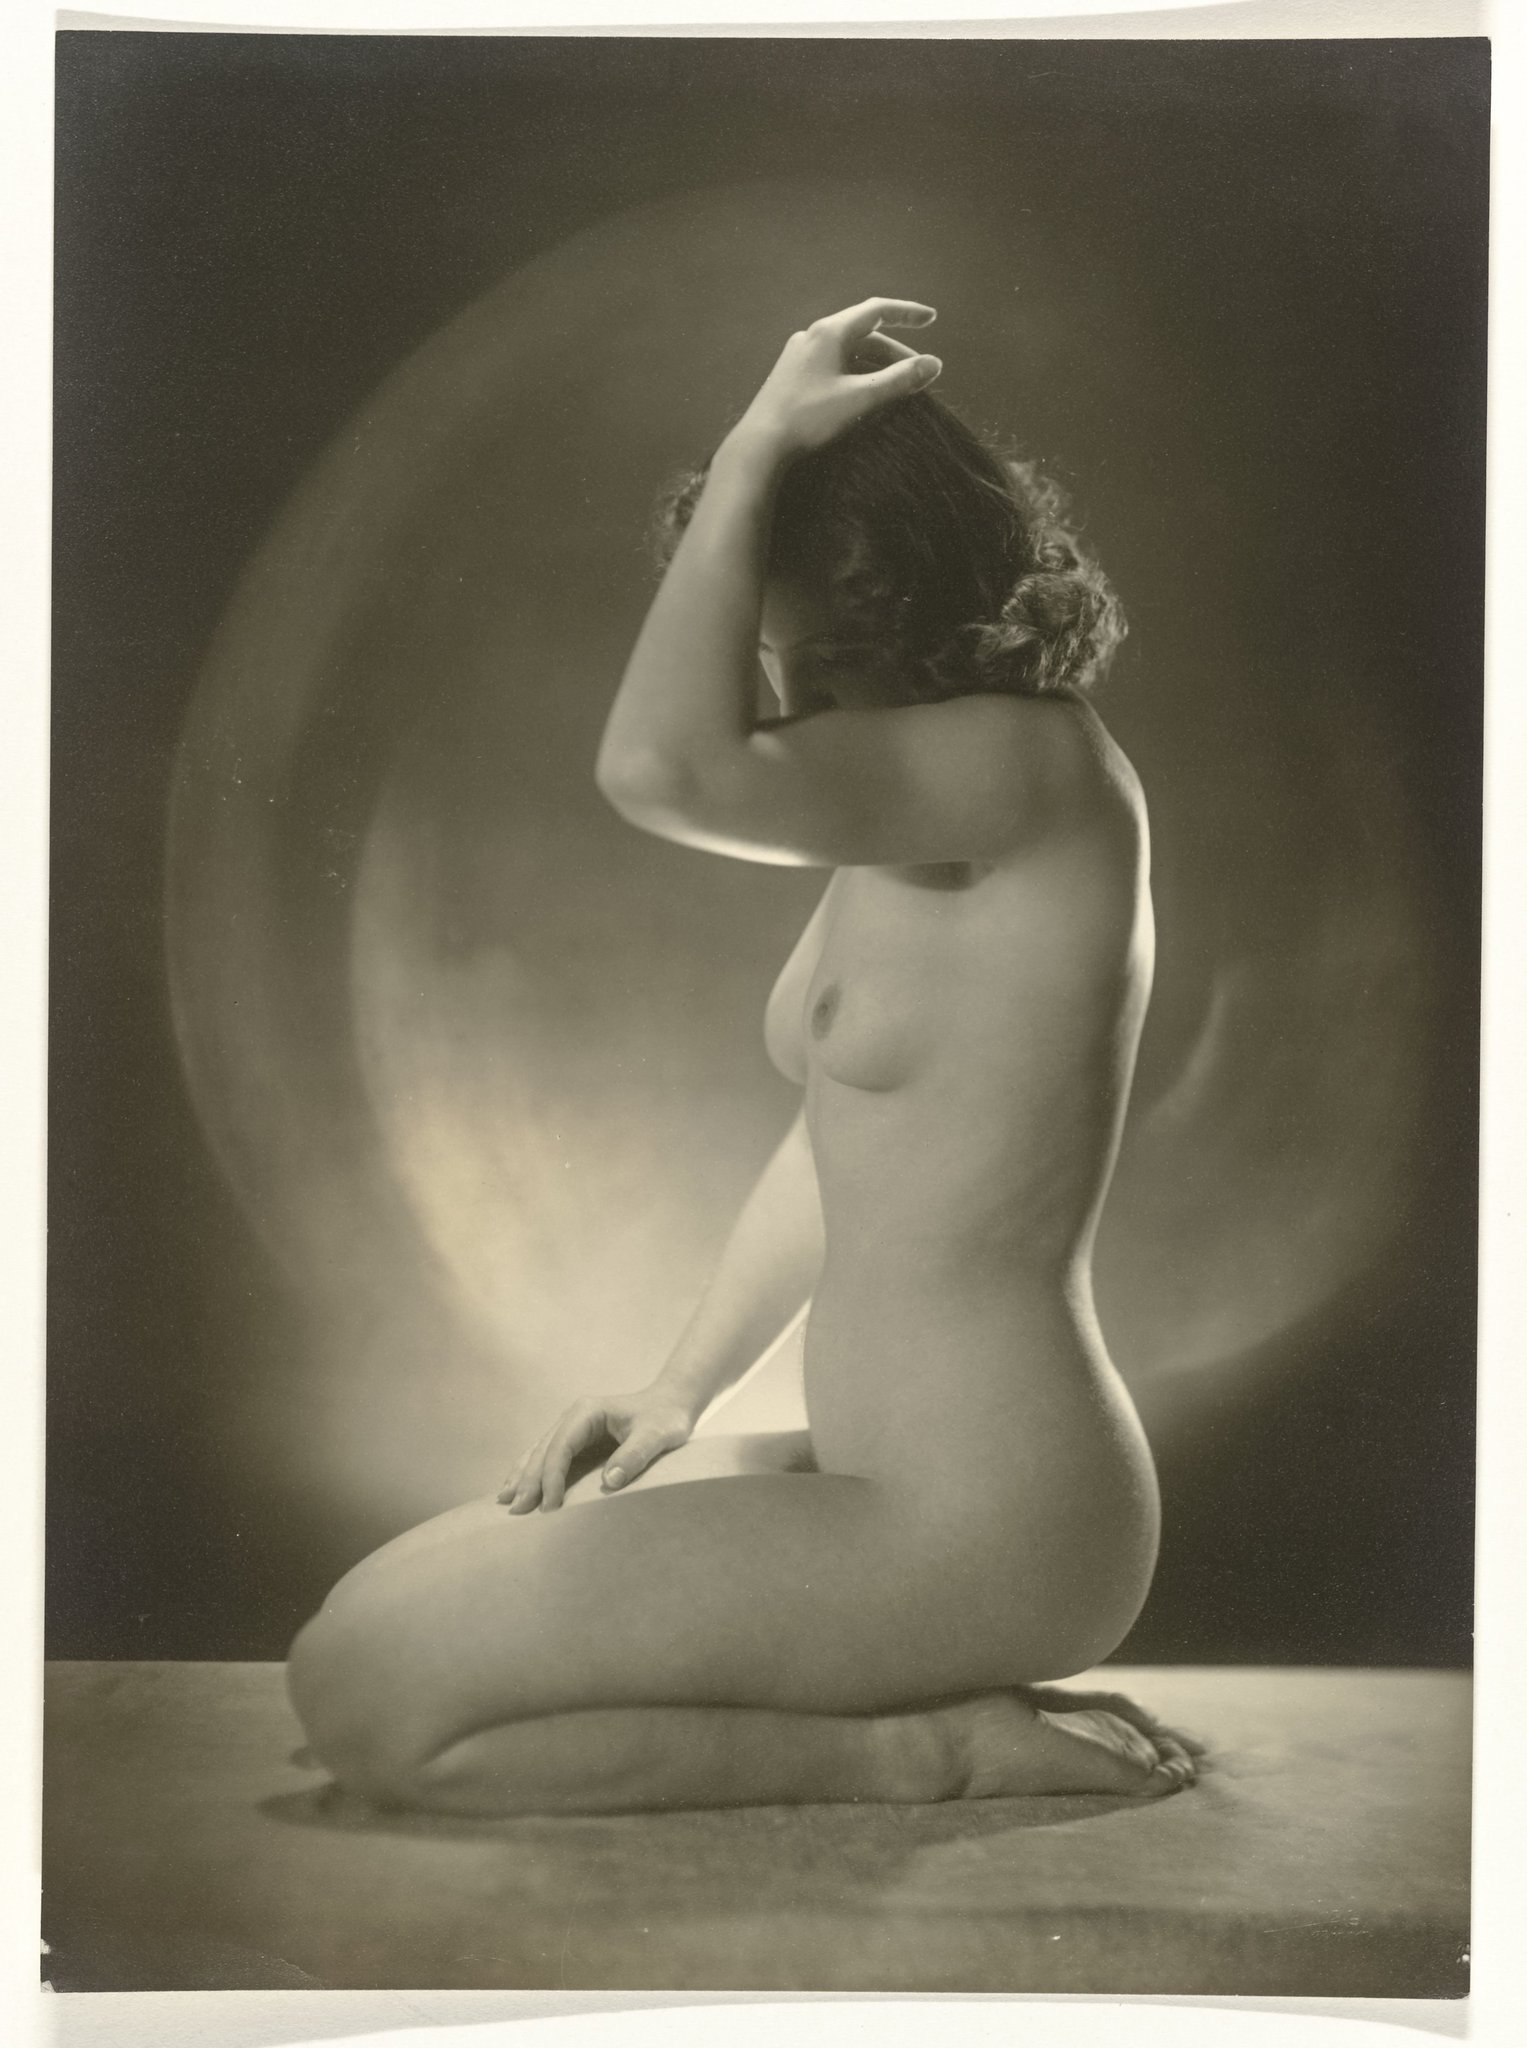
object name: photograph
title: Portret van een zittend naakt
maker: jacob merkelbach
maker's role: fotograaf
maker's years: 1877-1942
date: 1915-1930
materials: photographic support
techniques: gelatin silver print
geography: amsterdam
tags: historical persons not known by name - bb - woman, the (nude) human figure; 'corpo humano' (ripa) - aa - female human figure